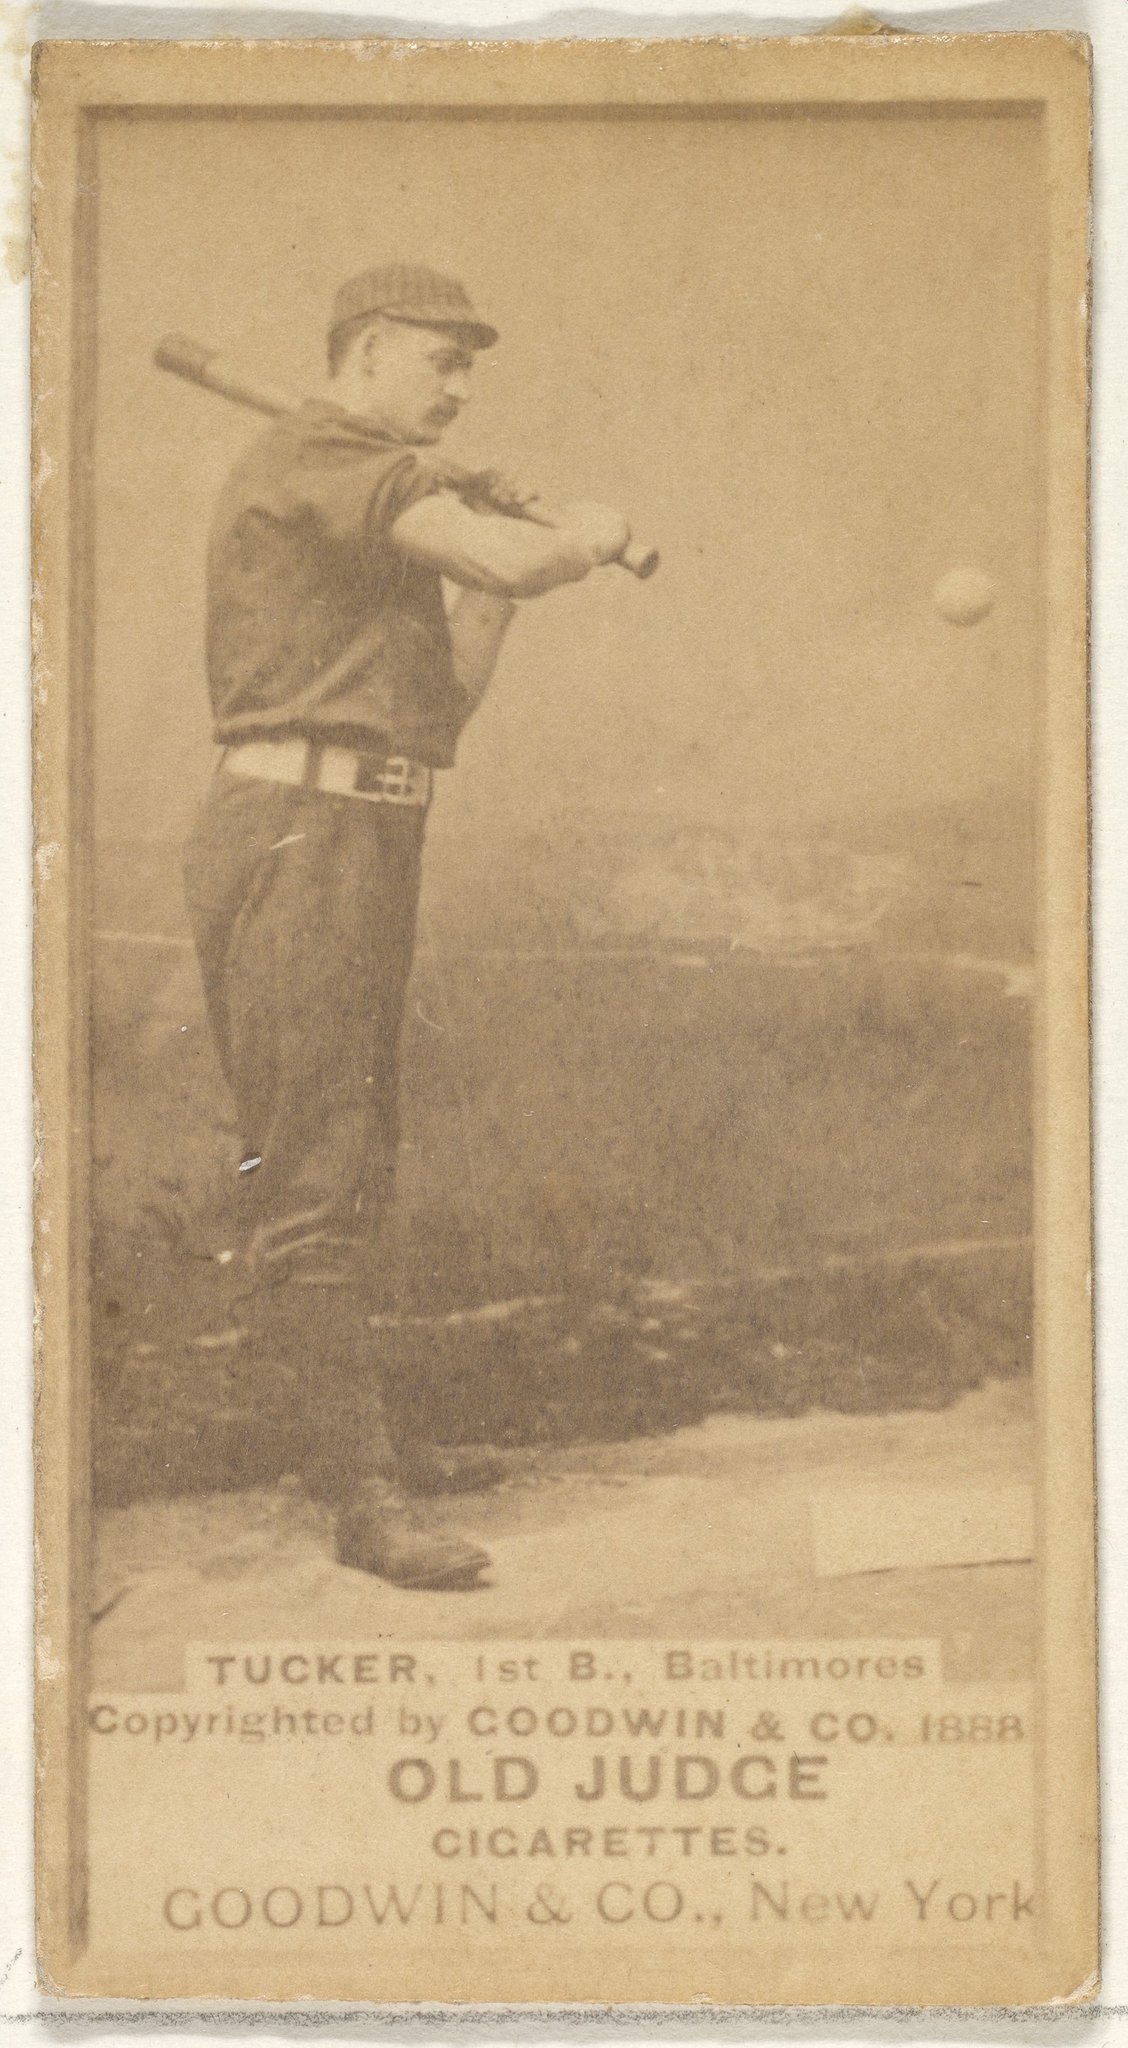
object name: baseball card, photograph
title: Tucker, 1st Base, Baltimore Orioles, from the Old Judge series (N172) for Old Judge Cigarettes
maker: goodwin & company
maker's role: publisher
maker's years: 1850-1950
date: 1888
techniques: albumen silver print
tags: men,portraits,baseball,athletes